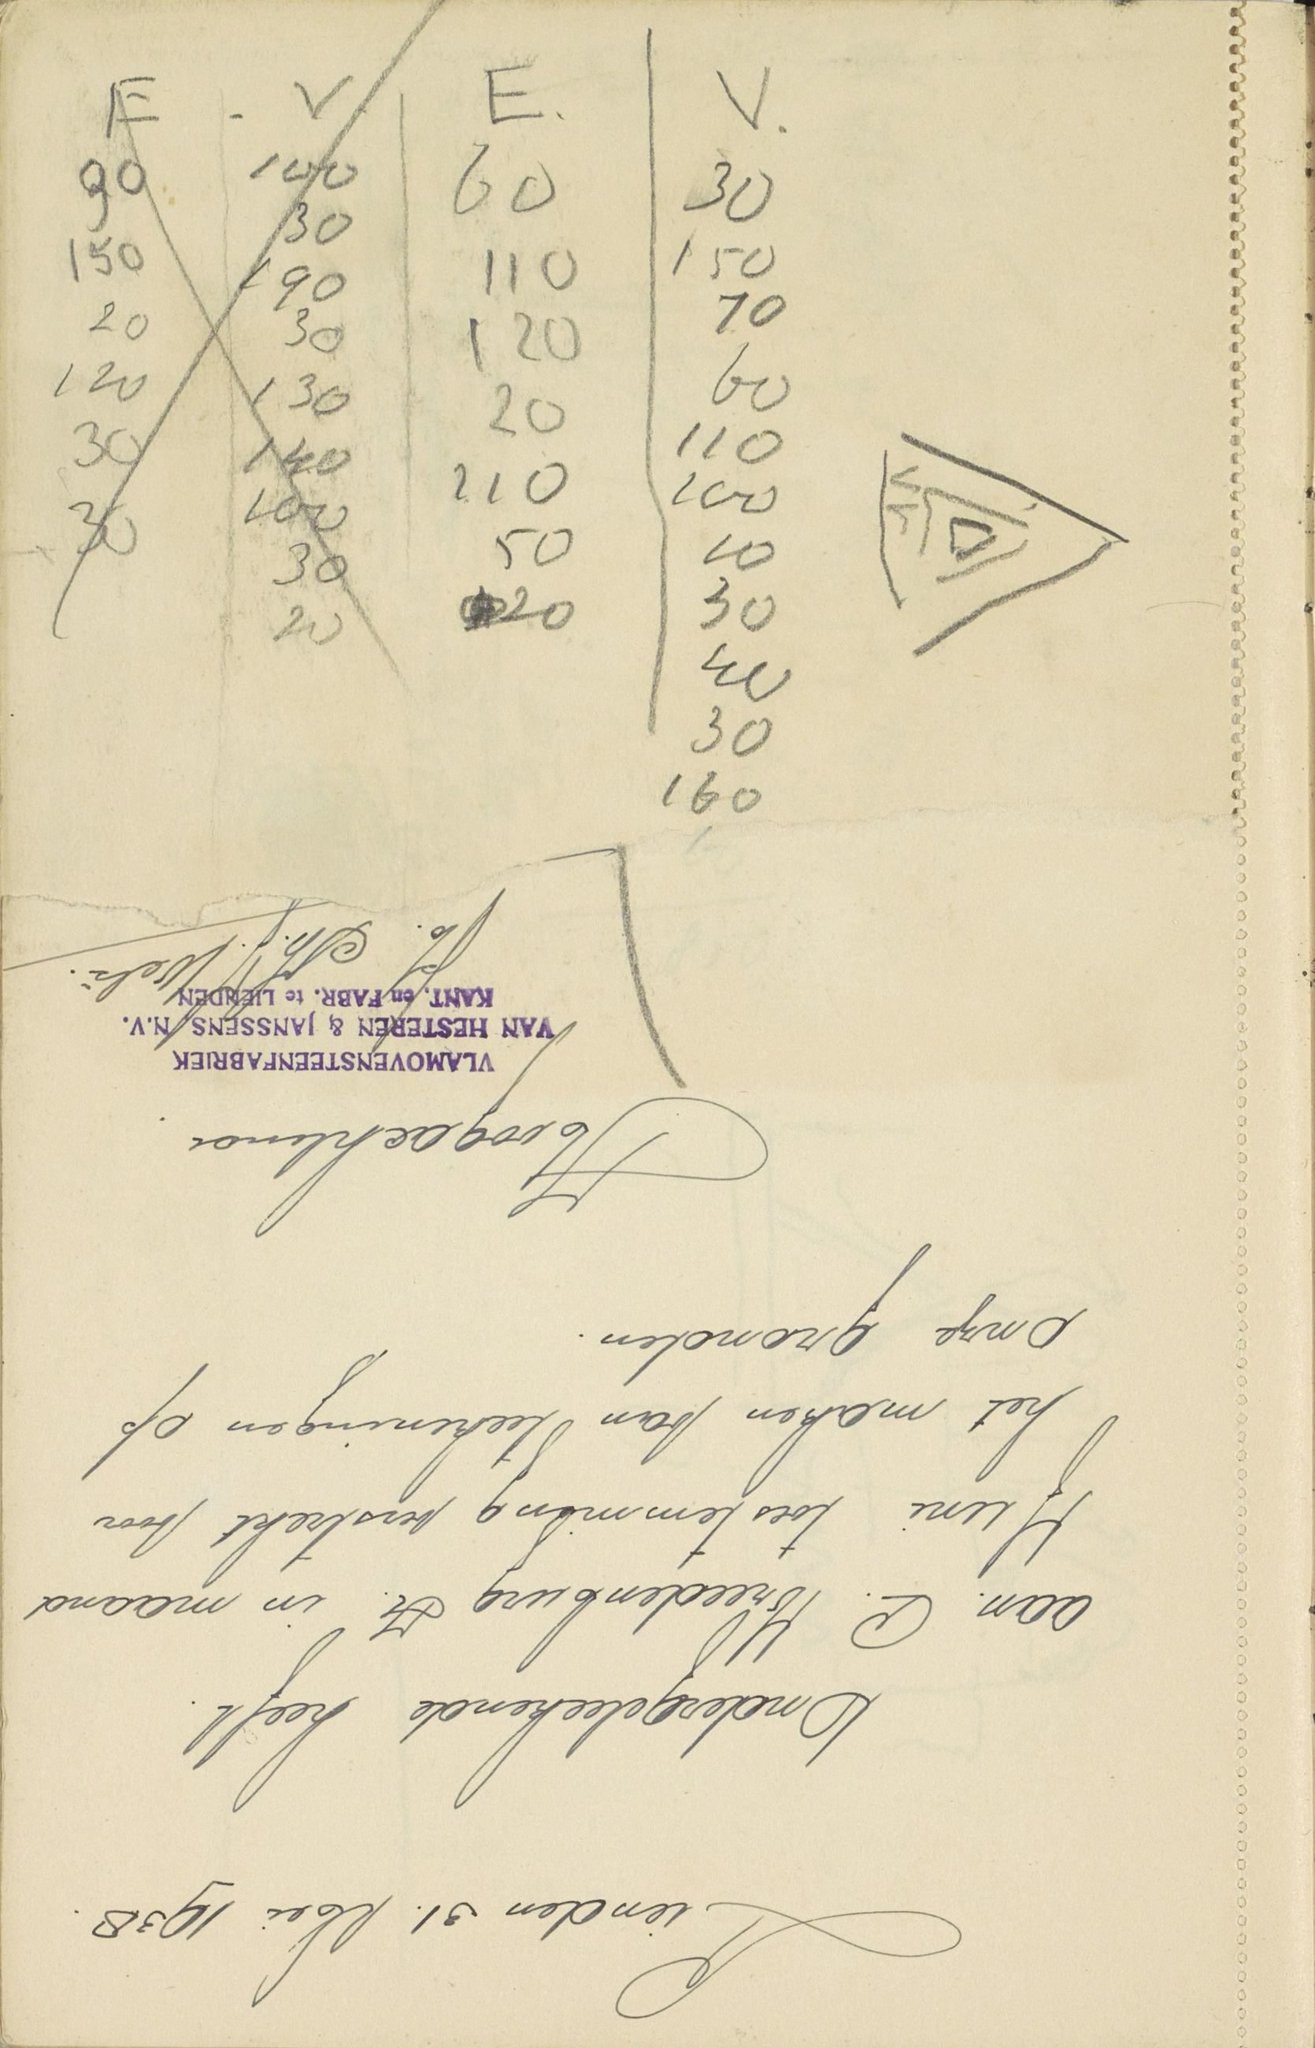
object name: sketchbook leaf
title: Toestemmingsbrief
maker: cornelis vreedenburgh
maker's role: draughtsman, print maker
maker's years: 1880-1946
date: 1890-1946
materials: ink, paper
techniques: pen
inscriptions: annotation: ‘Lienden 31 Mei 1938/ Ondergetekende heeft/ aan C. Vreedenburg Sr in maand/ Juni toestemming verstrekt voor/ het maken van teekeningen op/ onze gronden/ Hogachtend./ [...] Wels’, factory mark: ‘VLAMOVENSTEENFABRIEK/ VAN HESTEREN & JANSSENS N.V/ KANT. en FABR. te LIENDEN’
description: Blad 72 verso uit een schetsboek met 73 bladen.